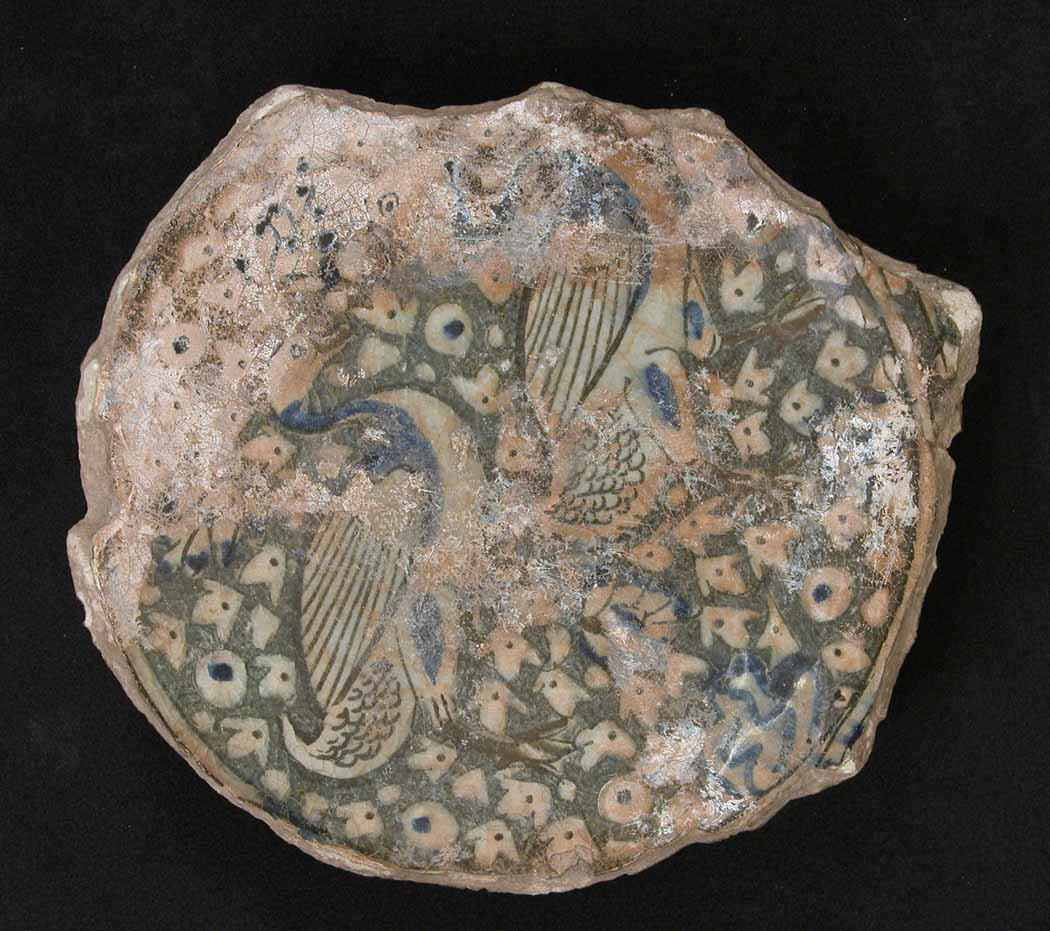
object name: fragment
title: Fragment of a Bowl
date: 1301-1400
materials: stonepaste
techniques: glazing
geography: iran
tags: birds